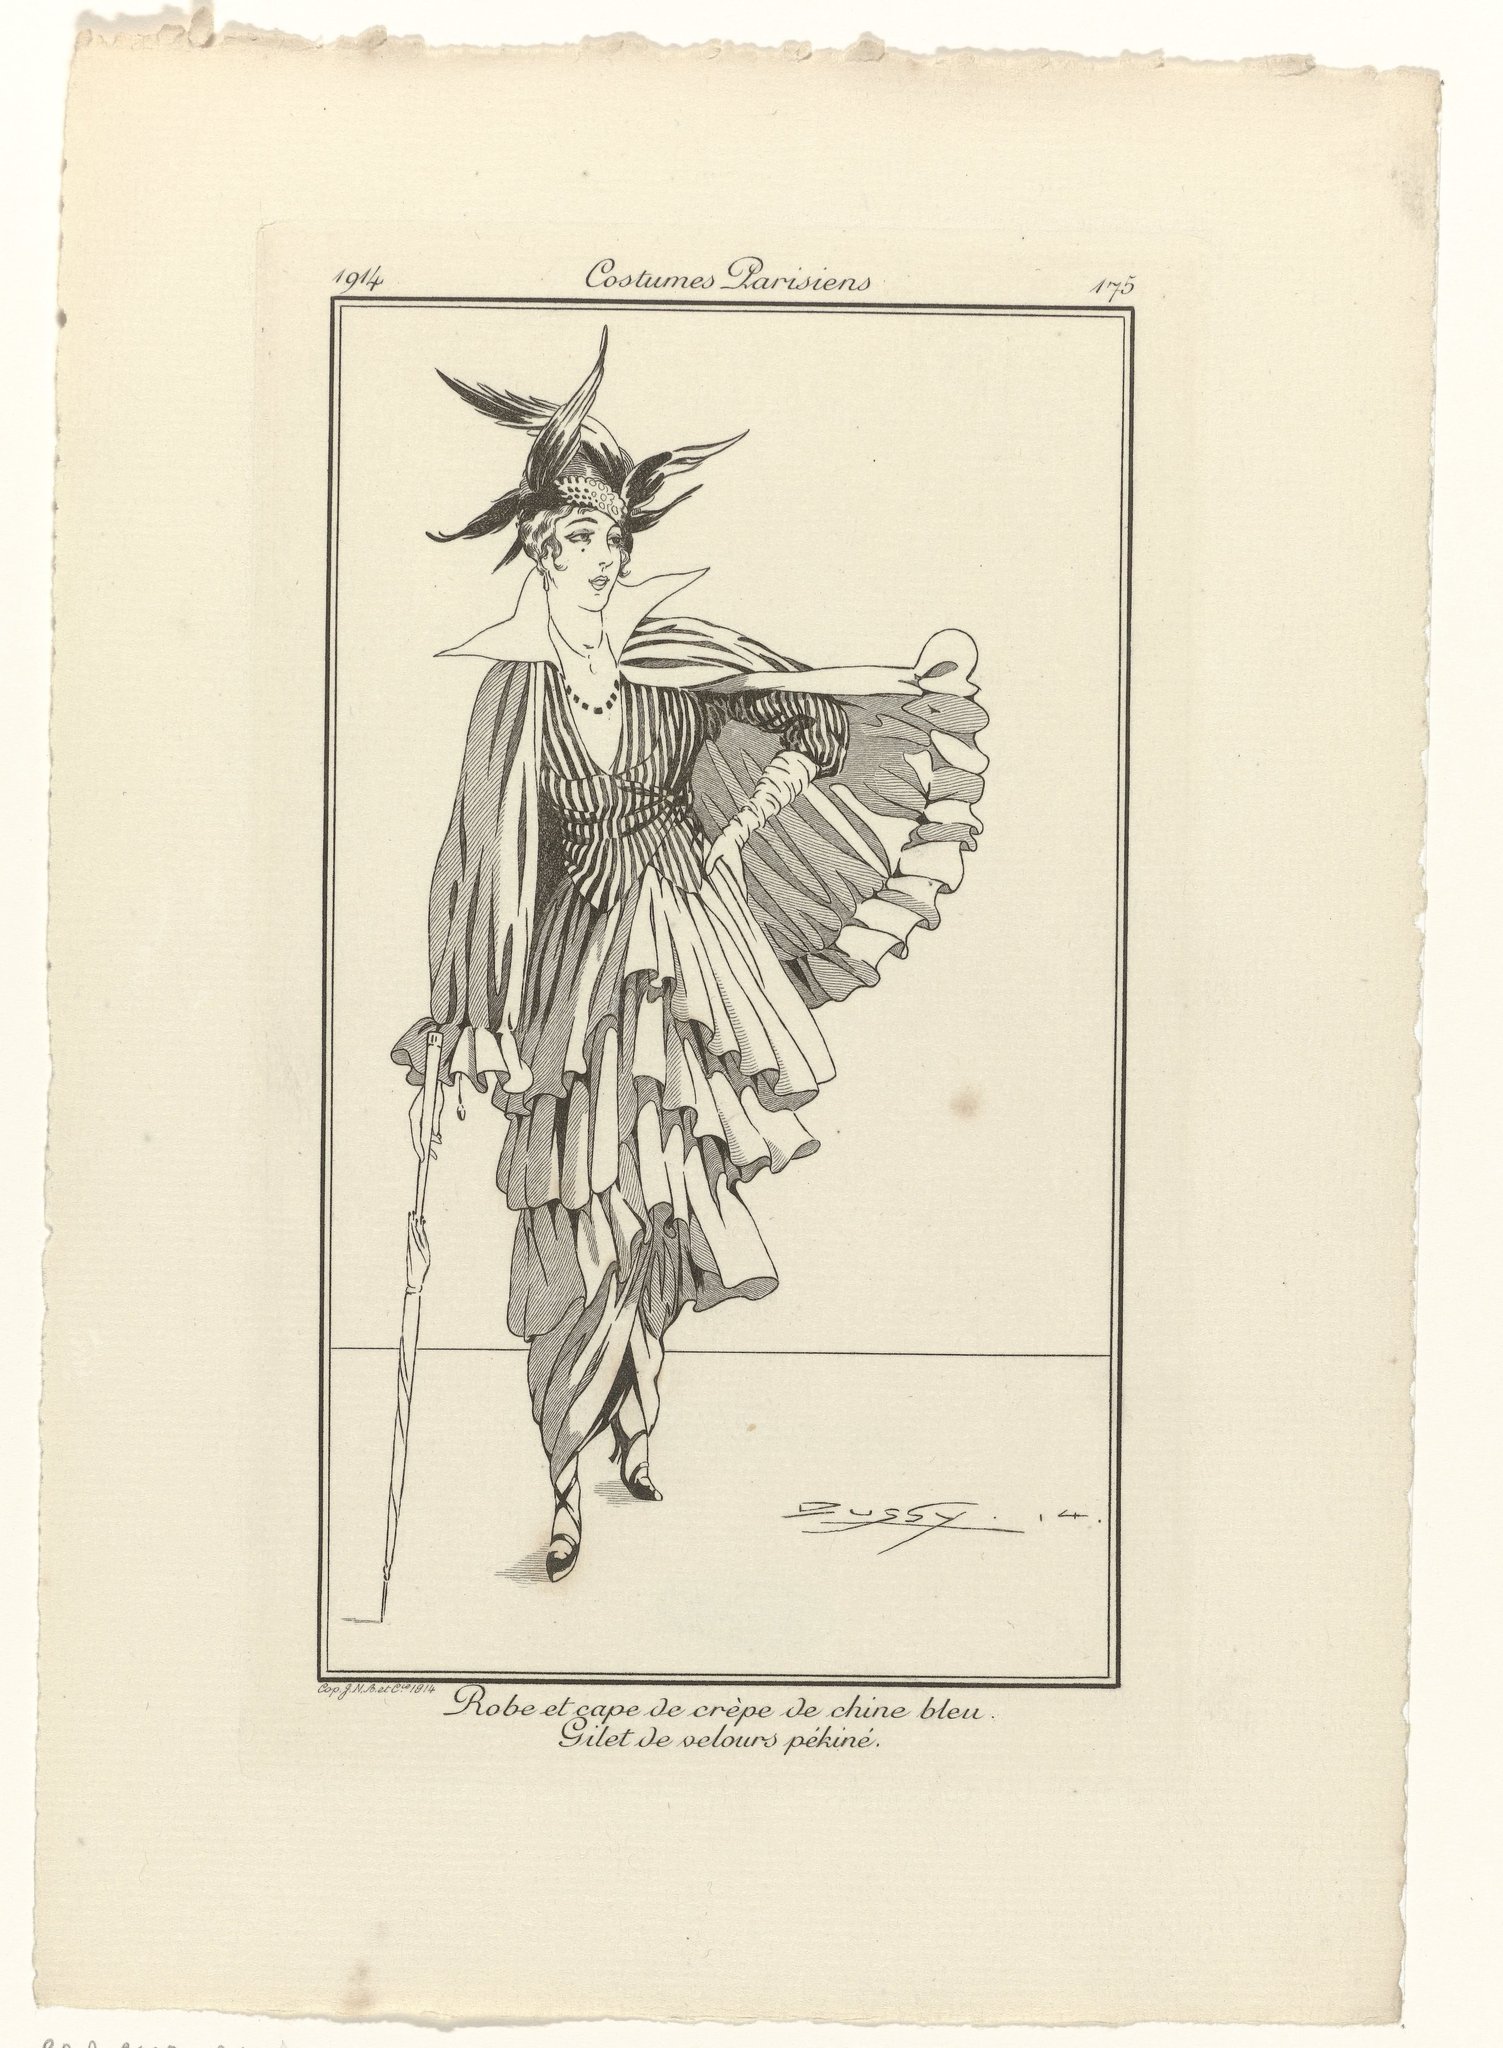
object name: fashion print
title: Journal des Dames et des Modes, Costumes Parisiens, 1914, No. 175 : Robe et cap (...)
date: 1914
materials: paper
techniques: engraving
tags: walking-stick, staff, cane (+ women's clothes), clothing for the upper part of the body (vest) (+ women's clothes), cape (+ women's clothes), fashion plates, head-gear: hat (+ women's clothes), dress, gown (+ women's clothes)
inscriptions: inscription: ‘Cop. J. N. A. et Cie 1914’, caption: ‘Robe et cape de crèpe de chine bleu. Gilet de velours pékiné.’, title: ‘Costumes Parisiens’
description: Japon en cape van blauwe crêpe de chine. Vest van 'velours pékiné'. Proefdruk van een prent uit het modetijdschrift Journal des Dames et des Modes (1912-1914).